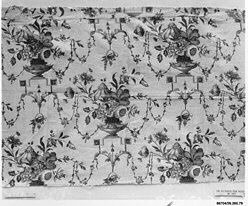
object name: piece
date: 1775-1785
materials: cotton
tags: flowers